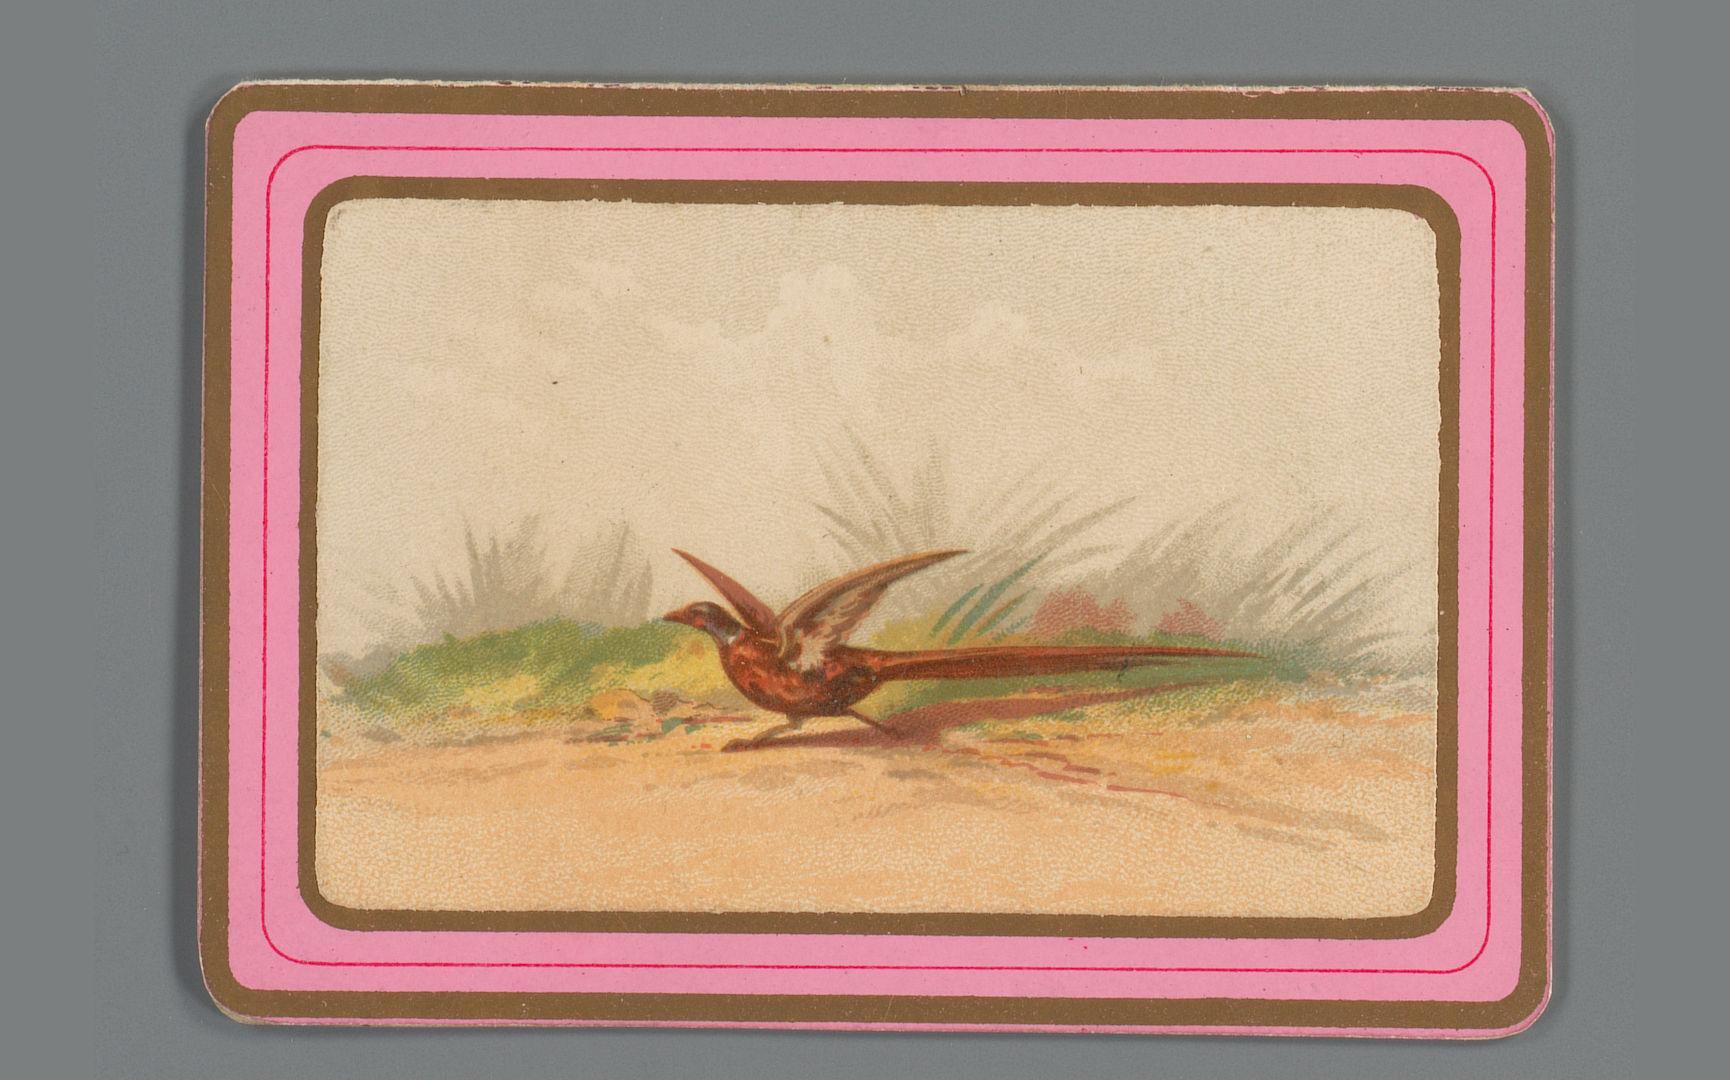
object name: marriage print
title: Souvenir bij het gouden huwelijksjubileum van Lucas Jonker en Maria Engelina Jonker van Zijp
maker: Anonymous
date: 1878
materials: paper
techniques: albumen print, chromolithography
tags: walker and runner birds: pheasant, marriage, married couple, 'matrimonium'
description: Op de voorzijde van de openslaande kaart: 'Souvenir der 50jarige Echtvereeniging van den Heer Lucas Jonker en Mevrouw Maria Engelina Jonker van Zijp. Bennebroek 27 Juli 1878'. Binnenin, in een decoratieve rand, portretten van de jubilarissen en een foto van een gevel, mogelijk het huis waar zij woonden. Op de achterzijde een prent met een fazant.